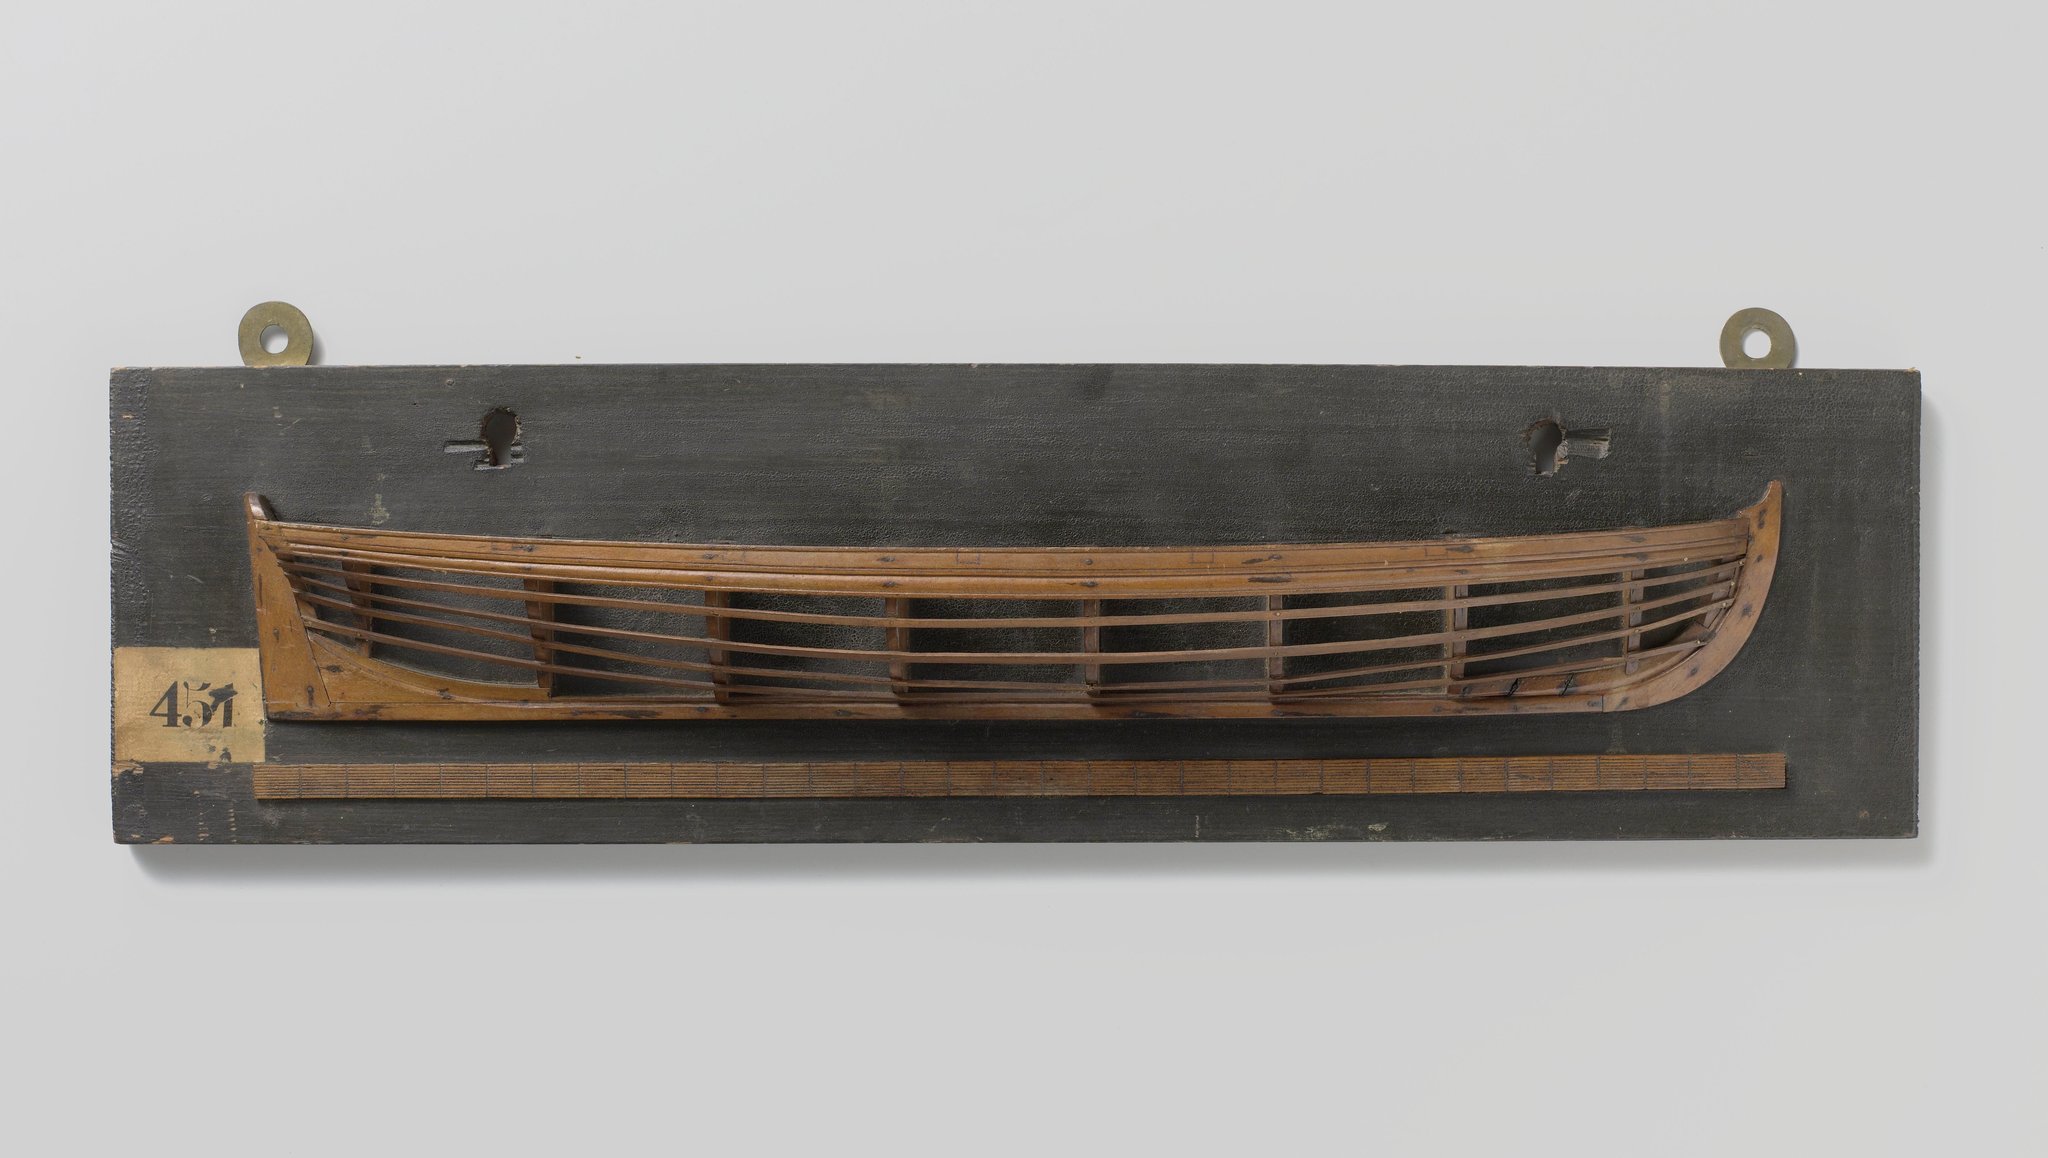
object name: ship model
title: Half Model of a Launch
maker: Anonymous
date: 1780-1820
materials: wood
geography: netherlands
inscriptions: label, bottom left: ‘451’ former inventory label, scale, bottom centre: wooden scale in Amsterdam feet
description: Mallenmodel (stuurboord) van een sloep. De huid boven het barkhout is gesloten en er zijn zes scheegaten aangegeven. Platte spiegel, miniatuur wulf, hekkebord. De zeeg loopt op naar beide uiteinden, één barkhout. Gepiekt rondspant. Schaal ca. 1:22 (schaal op model). Volgens de schaal is deze jol 32 voeten lang.